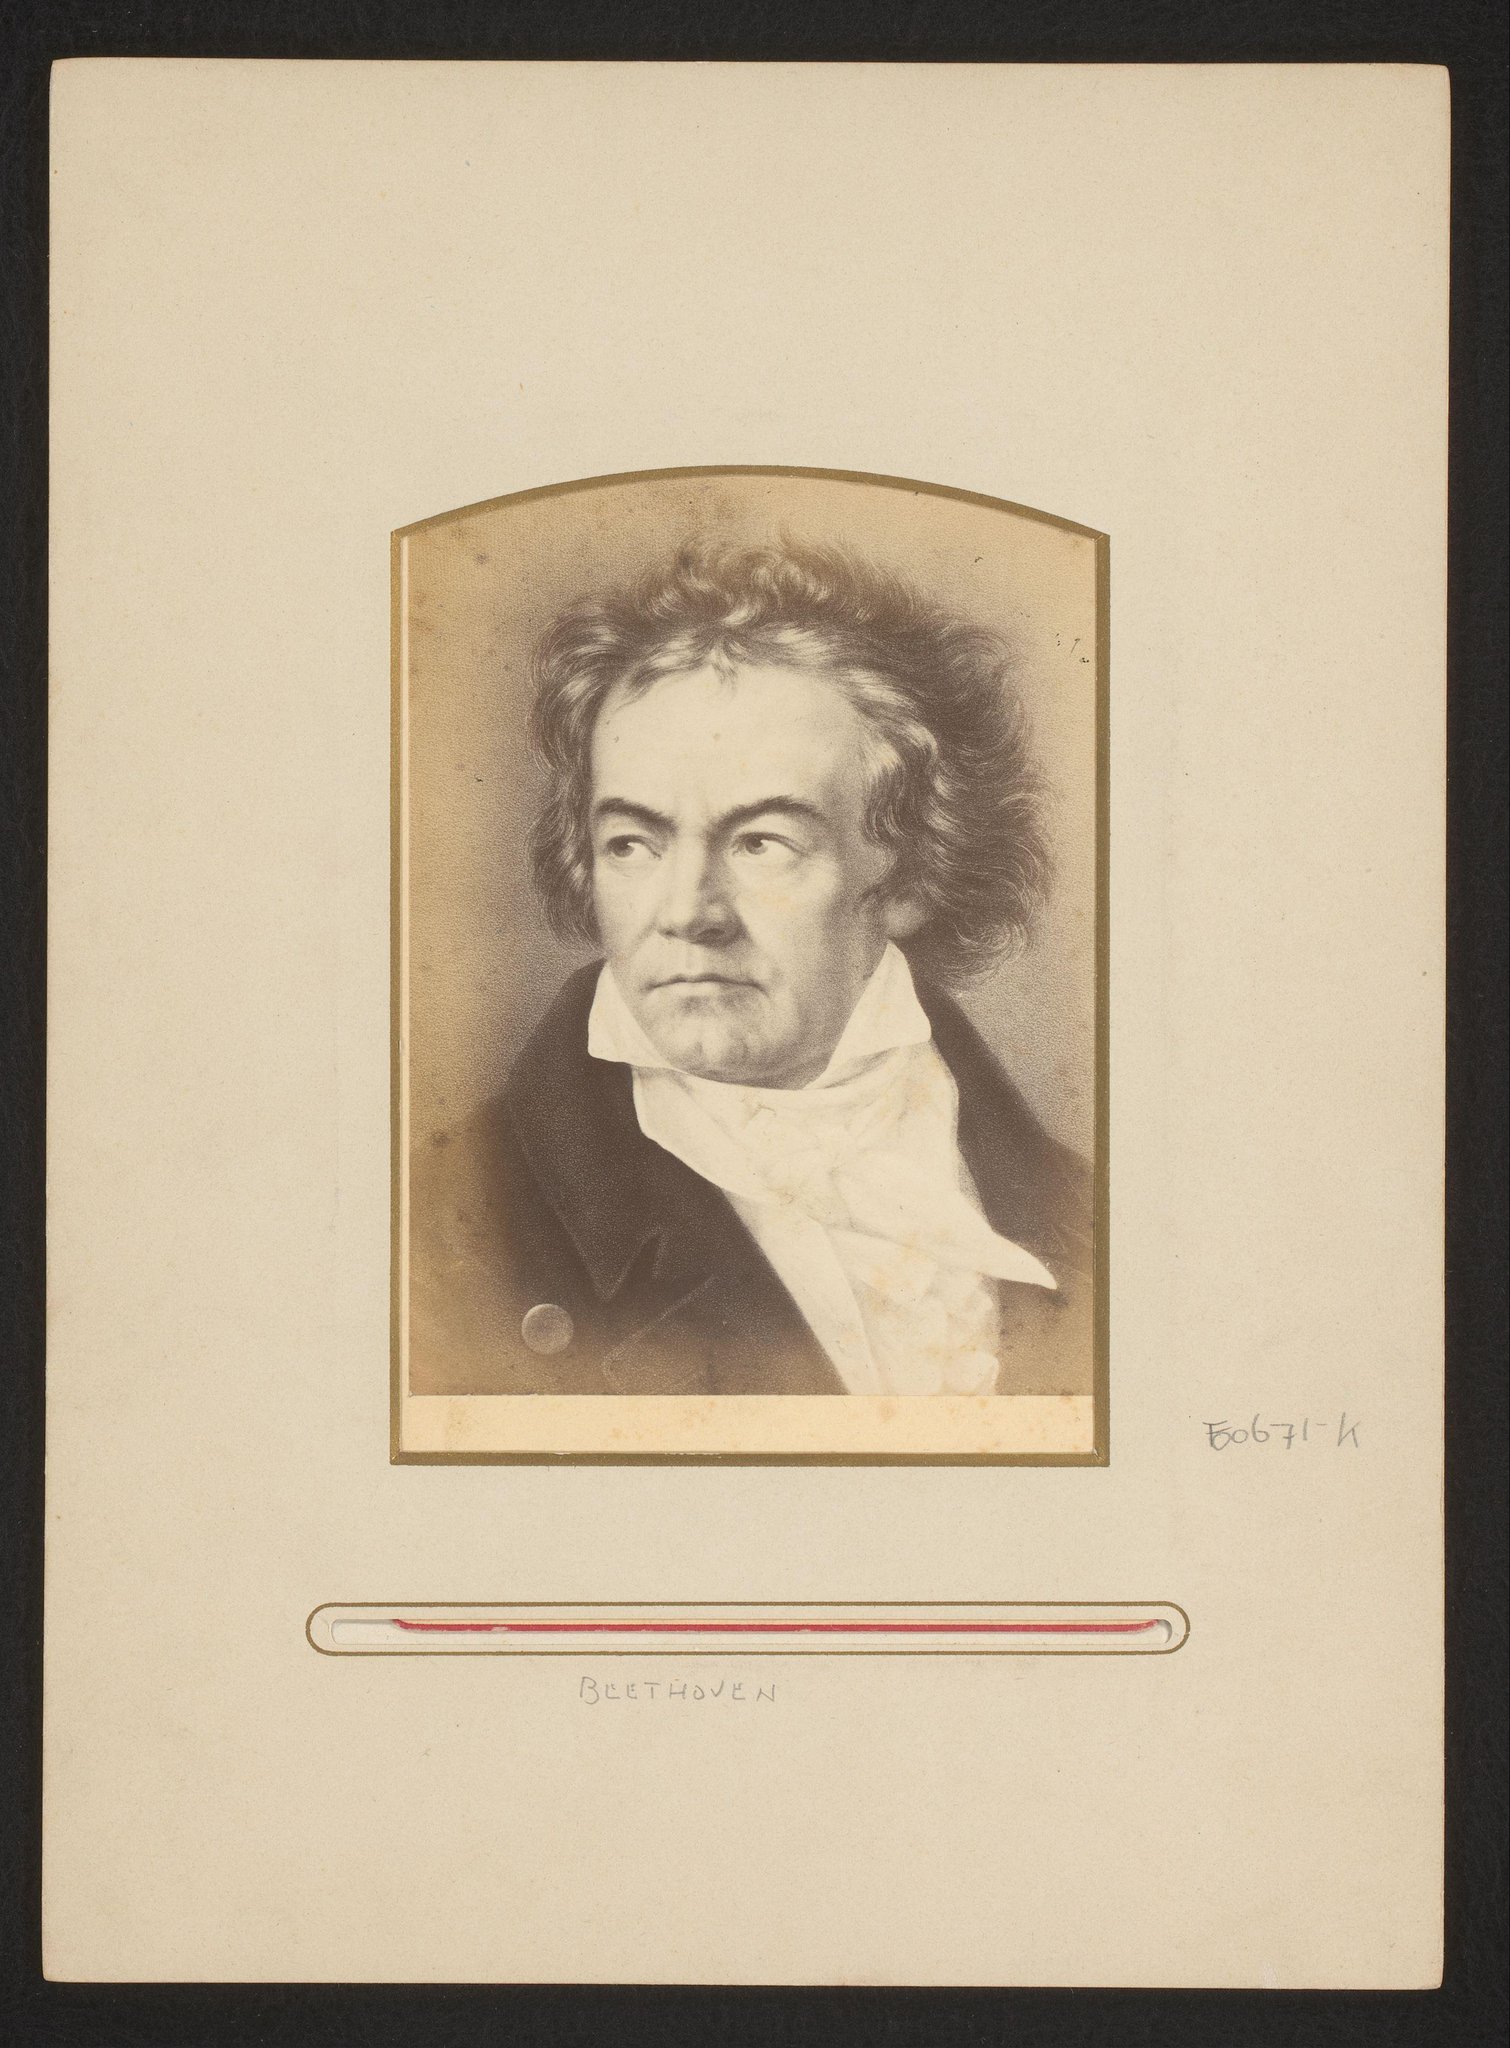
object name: reproduction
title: Fotoreproductie van een getekend portret Ludwig van Beethoven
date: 1870-1900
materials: cardboard, photographic support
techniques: albumen print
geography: berlin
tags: vienna, historical persons, portrait of composer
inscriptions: inscription: ‘L. van Beethoven/ (1819.)’, name: ‘Beethoven’, inscription: ‘Eigenthum und Verlag von/ E.H. Schroeder/ Hermann Kaiser/ Berlin/ 41. Unter den Linden 41./ Phot. G. Schauer./ Berlin./ Typ. G Lange (O. Lange)’